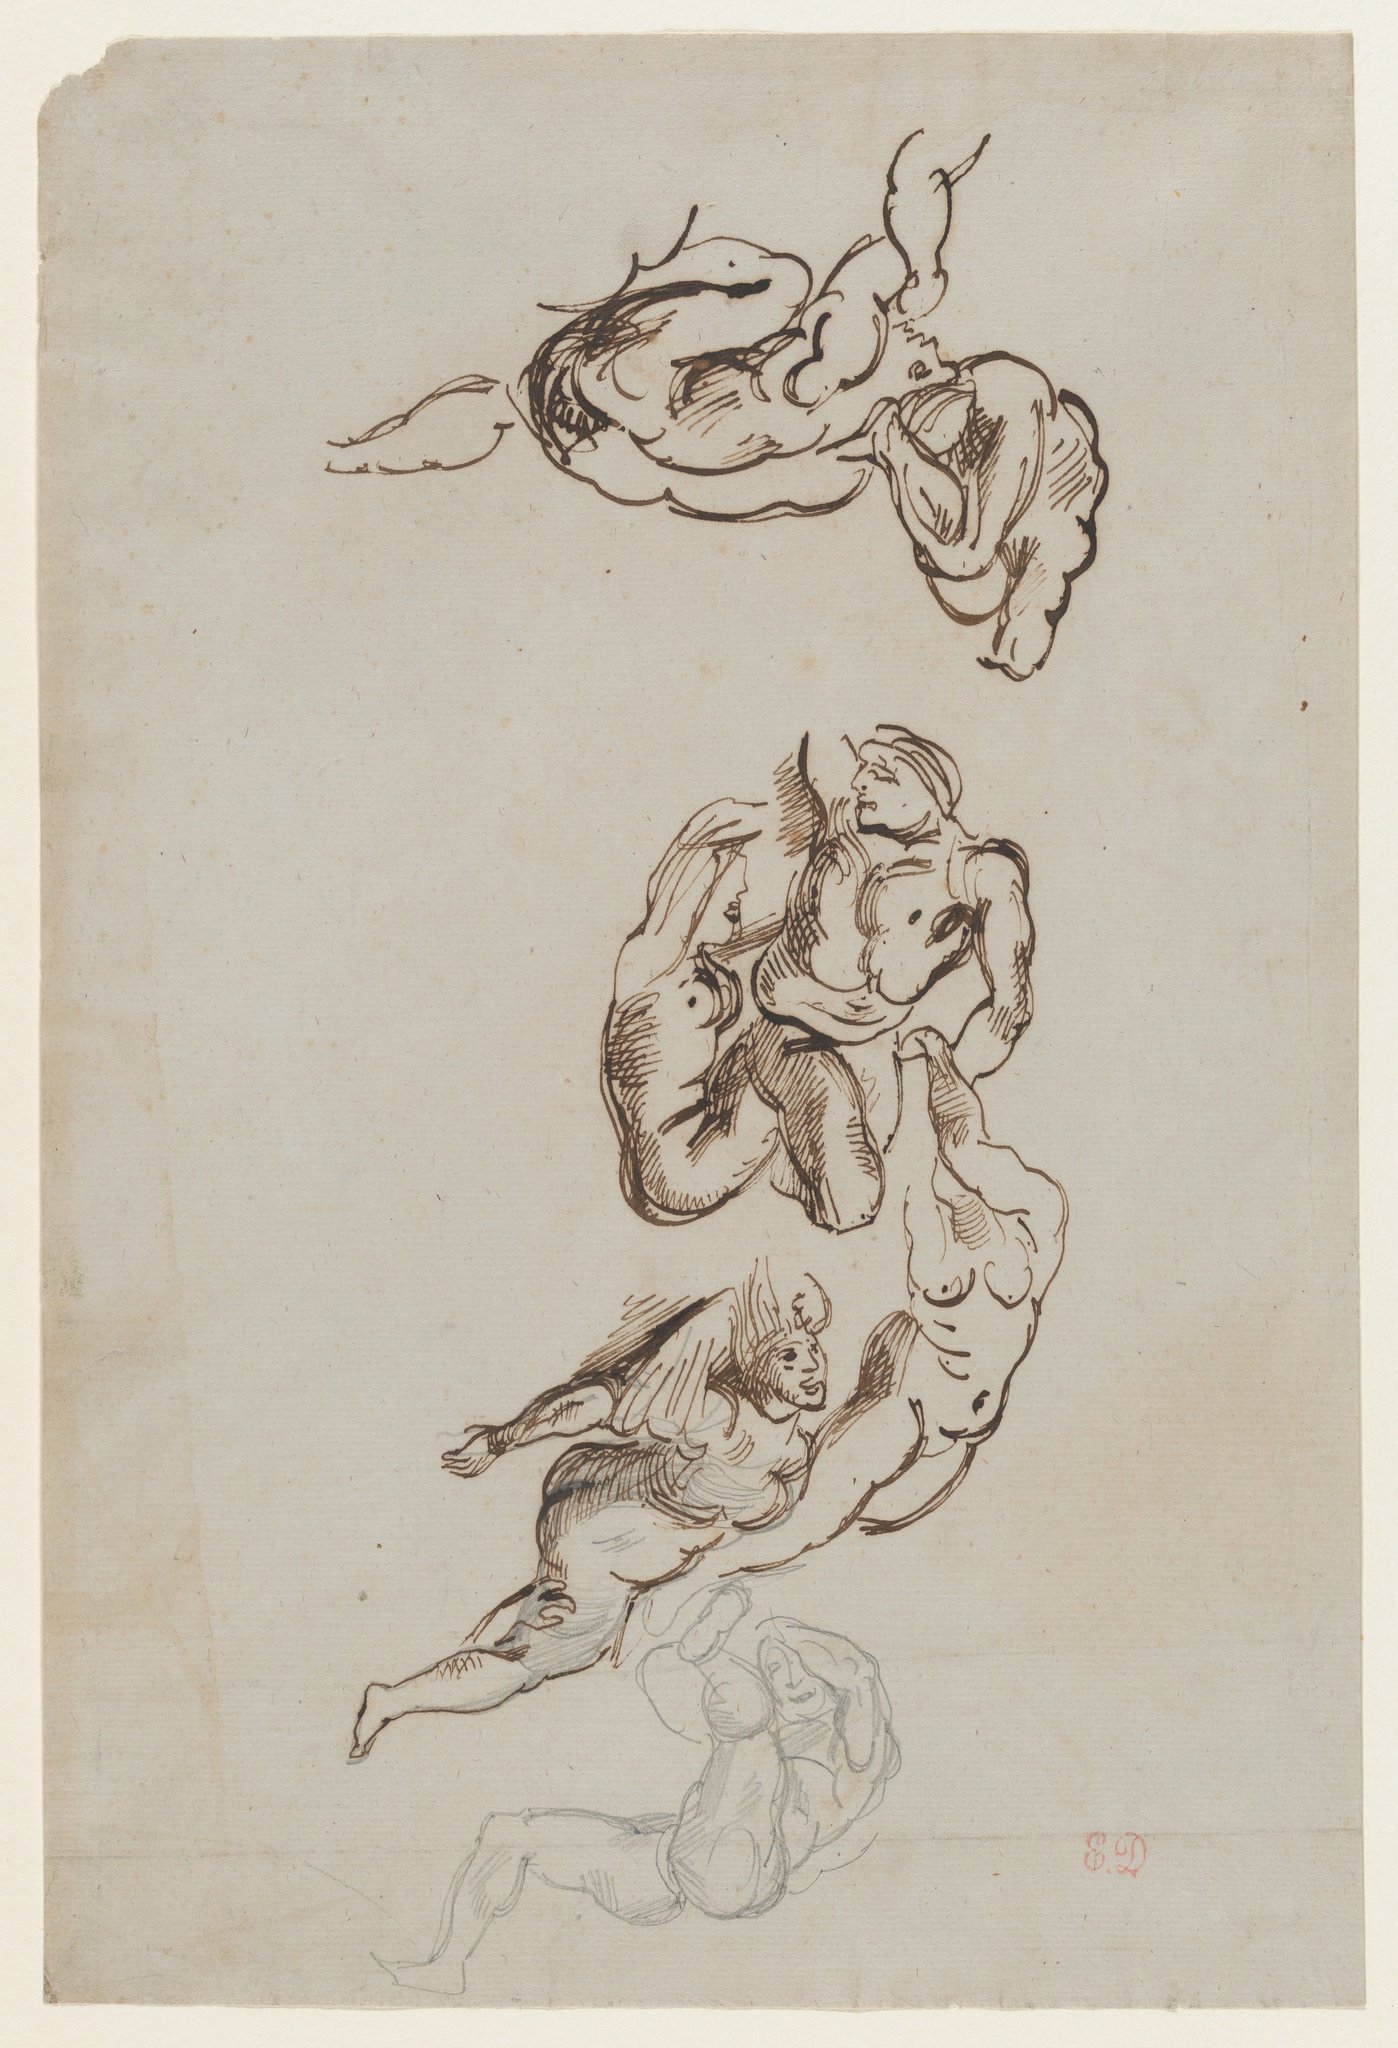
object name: drawing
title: Figure Studies after Rubens's "The Fall of the Rebel Angels"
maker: eugène delacroix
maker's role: artist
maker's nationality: french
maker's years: 1798-1863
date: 1820-1822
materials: graphite, ink, iron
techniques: pen